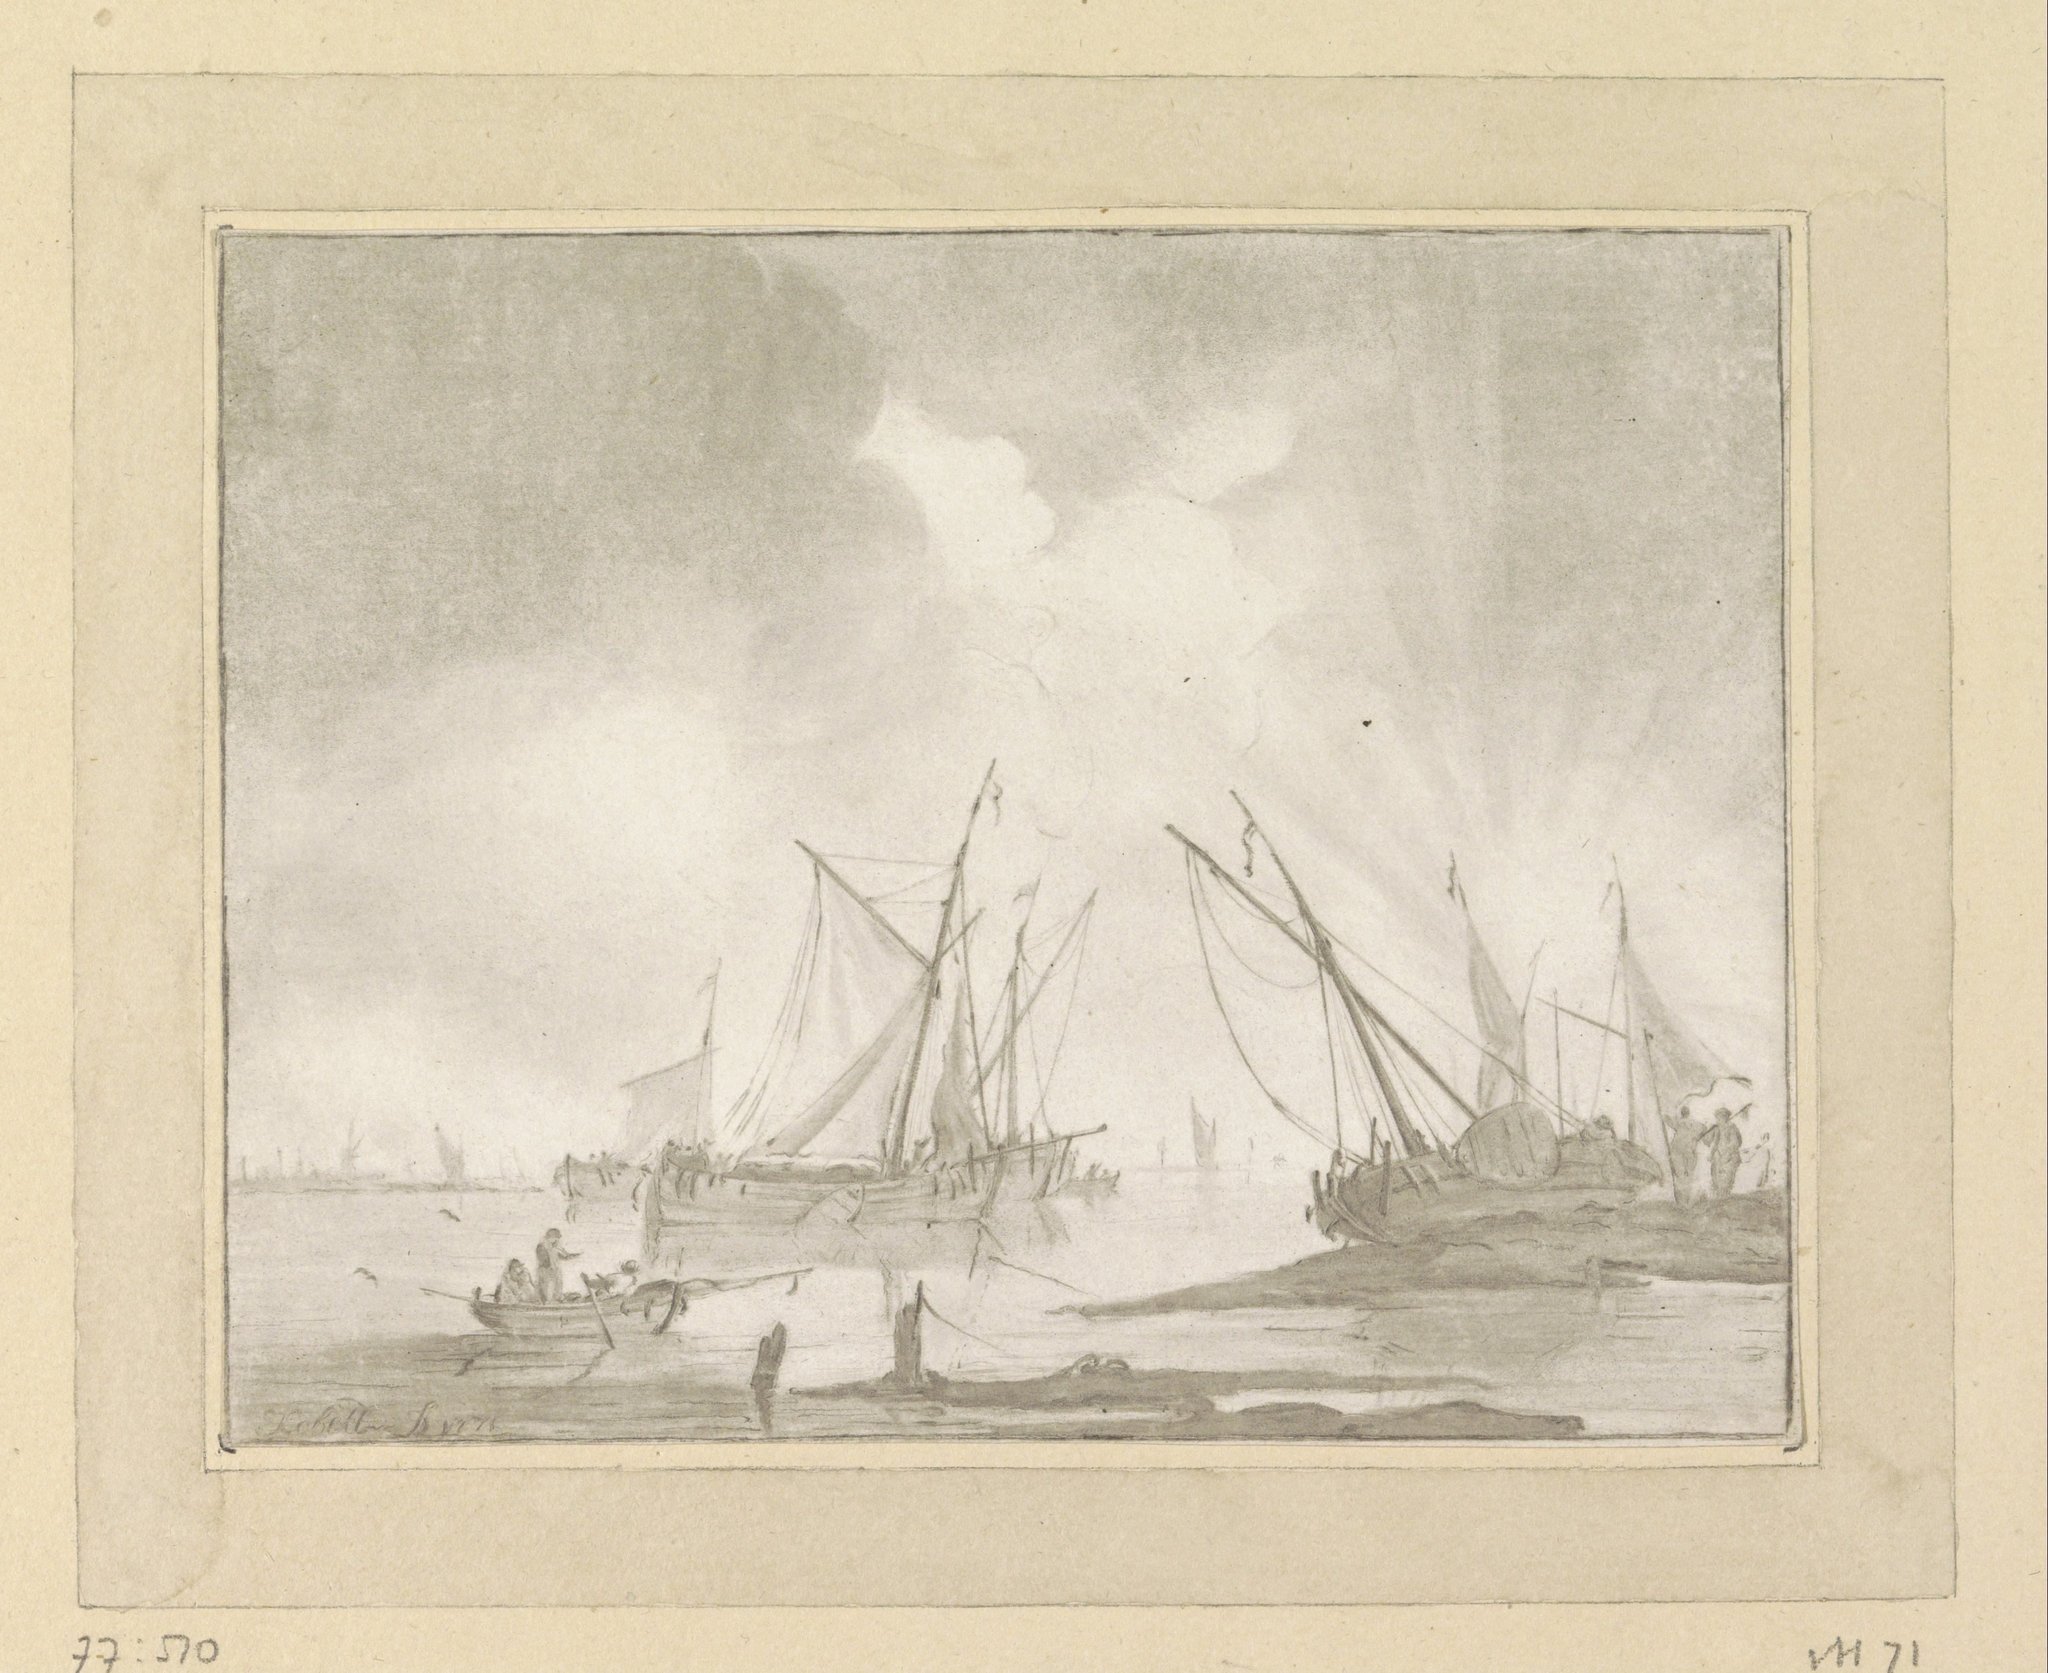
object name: print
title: Rivierlandschap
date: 1771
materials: paper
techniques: transfer, print drawing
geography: amsterdam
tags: sailing-ship, sailing-boat, river (+ landscape with figures, staffage), river bank (+ landscape with figures, staffage)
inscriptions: collector's mark: Lugt 2228